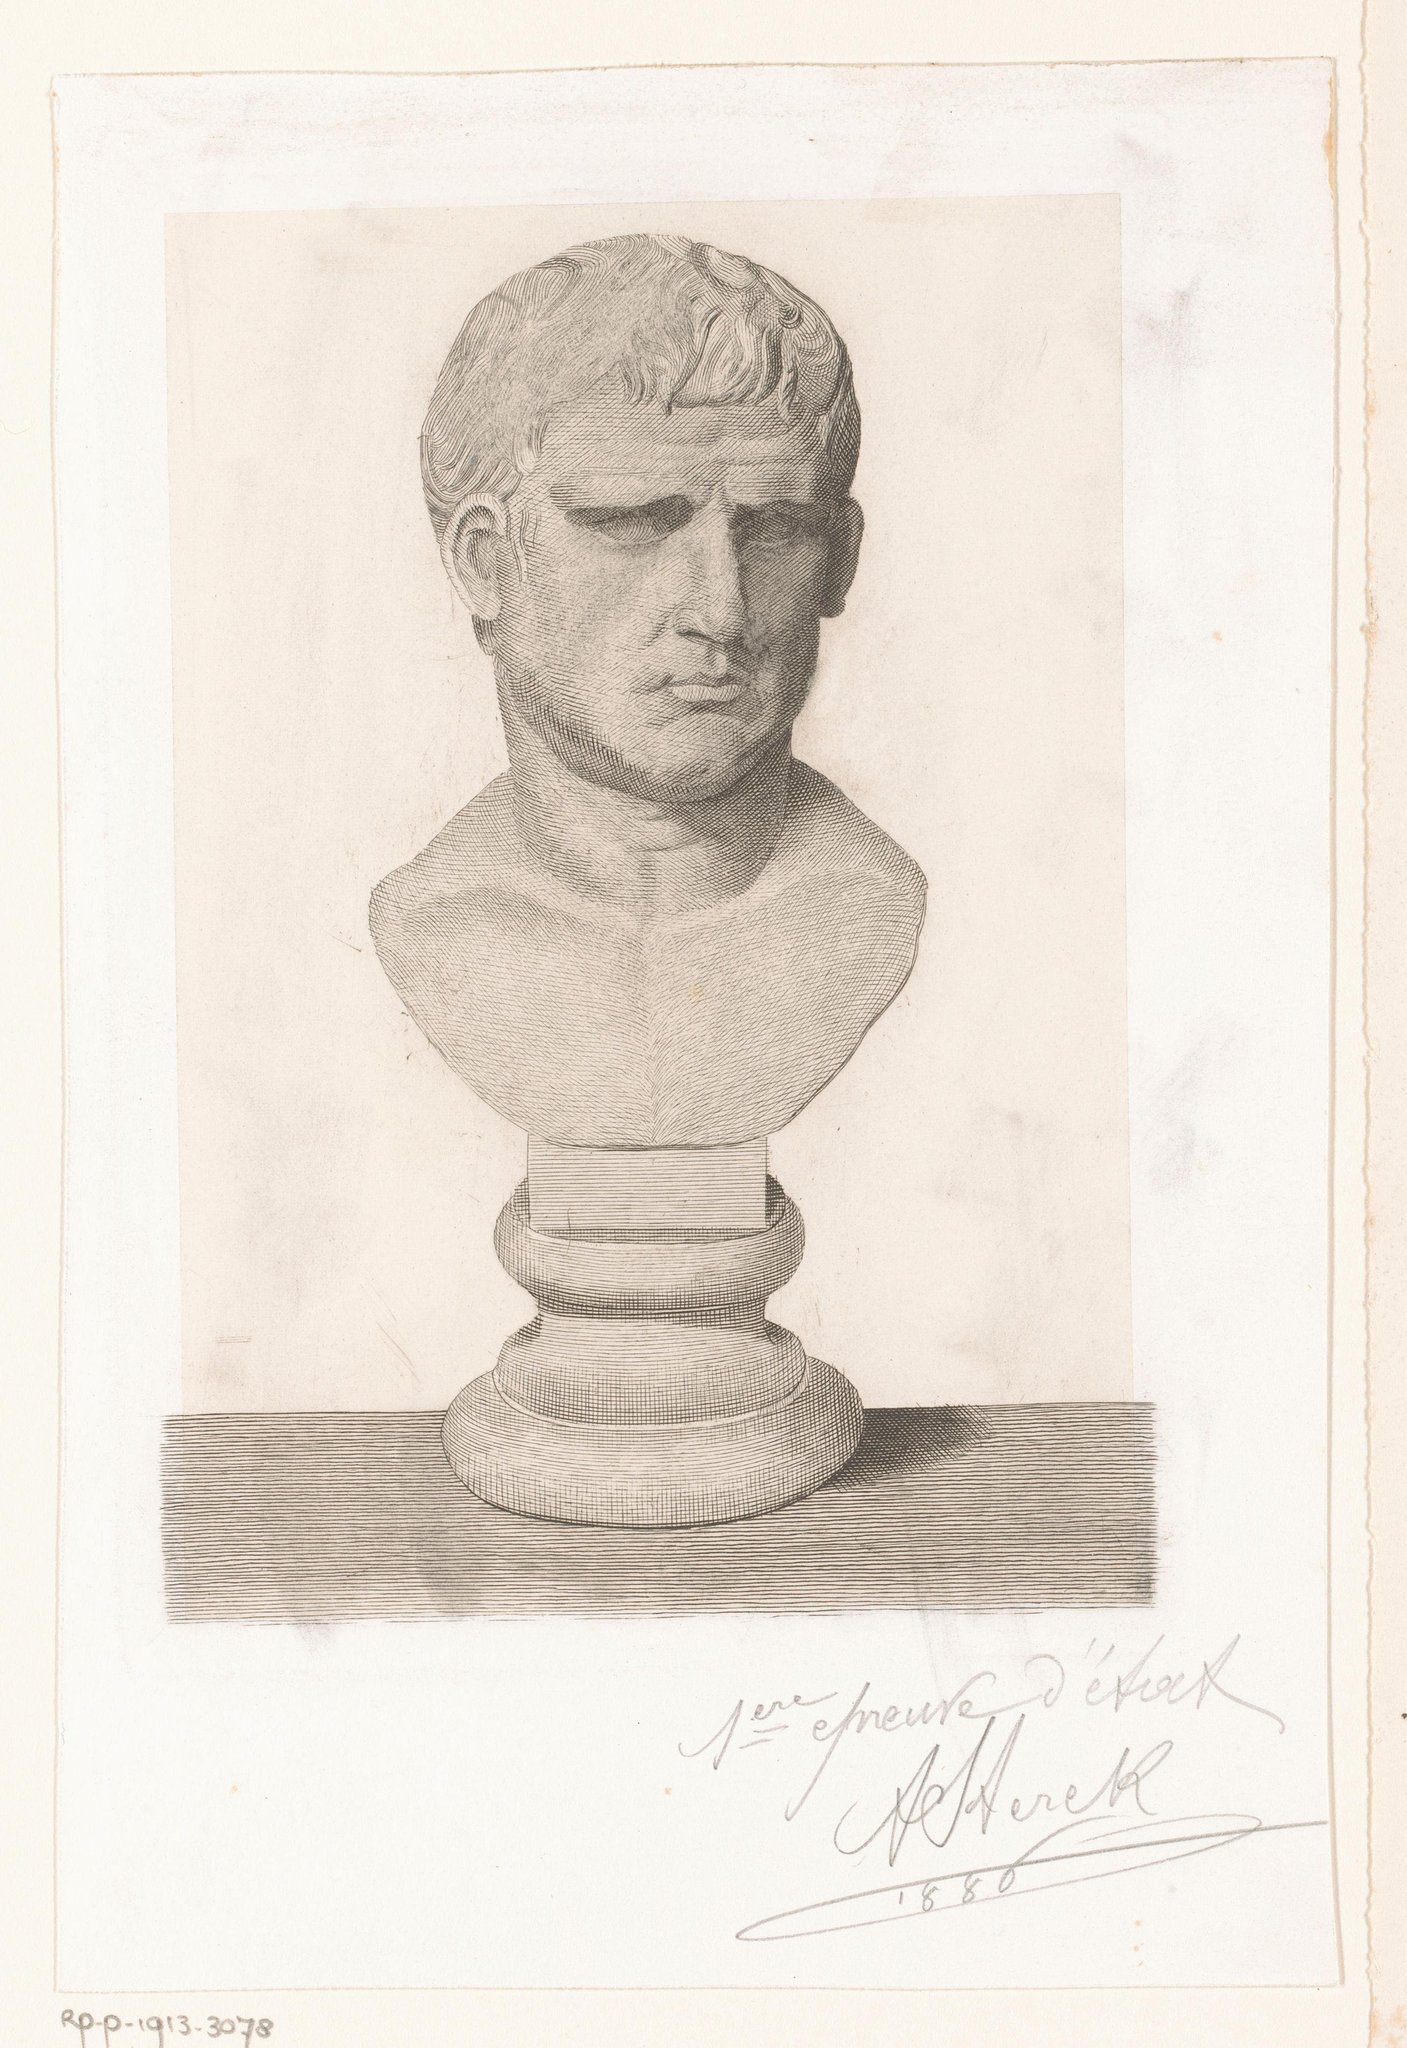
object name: print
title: Buste van Marcus Vipsanius Agrippa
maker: arthur sterck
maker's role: print maker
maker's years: 1868-1897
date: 1886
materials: paper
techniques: etching, intaglio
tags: campania, chest, bust, piece of sculpture, reproduction of a piece of sculpture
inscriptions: collector's mark: Lugt 2228, annotation: ‘1ere epreuve d'état’